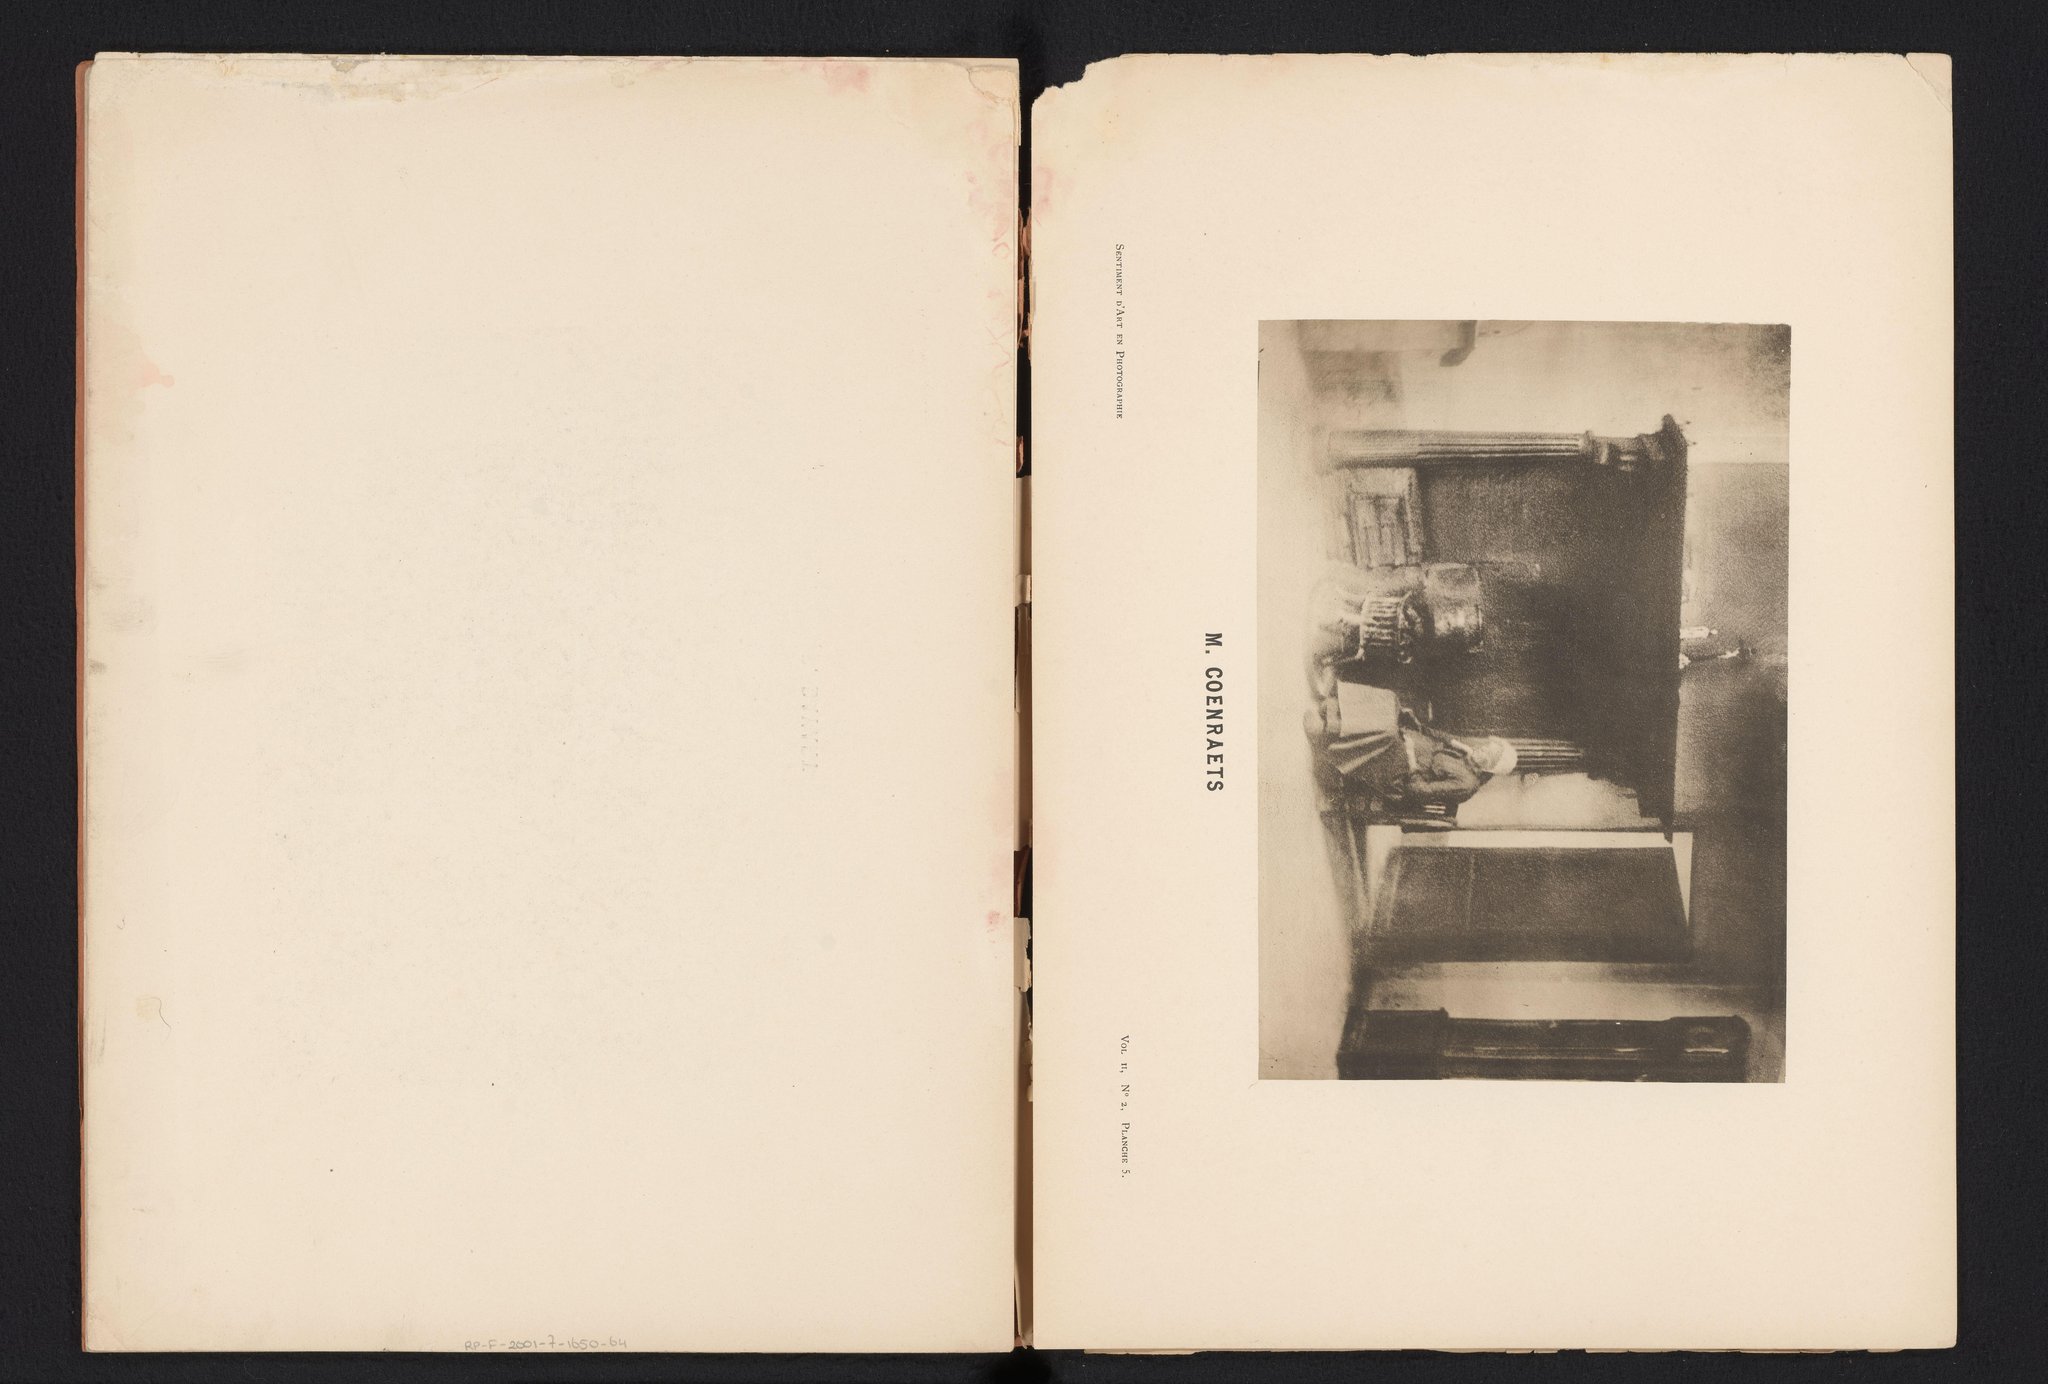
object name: photomechanical print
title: Vrouw op een stoel bij een haard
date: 1895-1900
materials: paper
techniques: photograph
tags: adult woman, warming oneself at a fire (or hearth, stove, fire-pan, brazier)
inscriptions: number: ‘Vol. II, No 2, Planche 5.’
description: Deze prent maakt deel uit van 8 omslagen met 22 tekstbladen en 89 prenten op losse bladen in en tussen de omslagen.